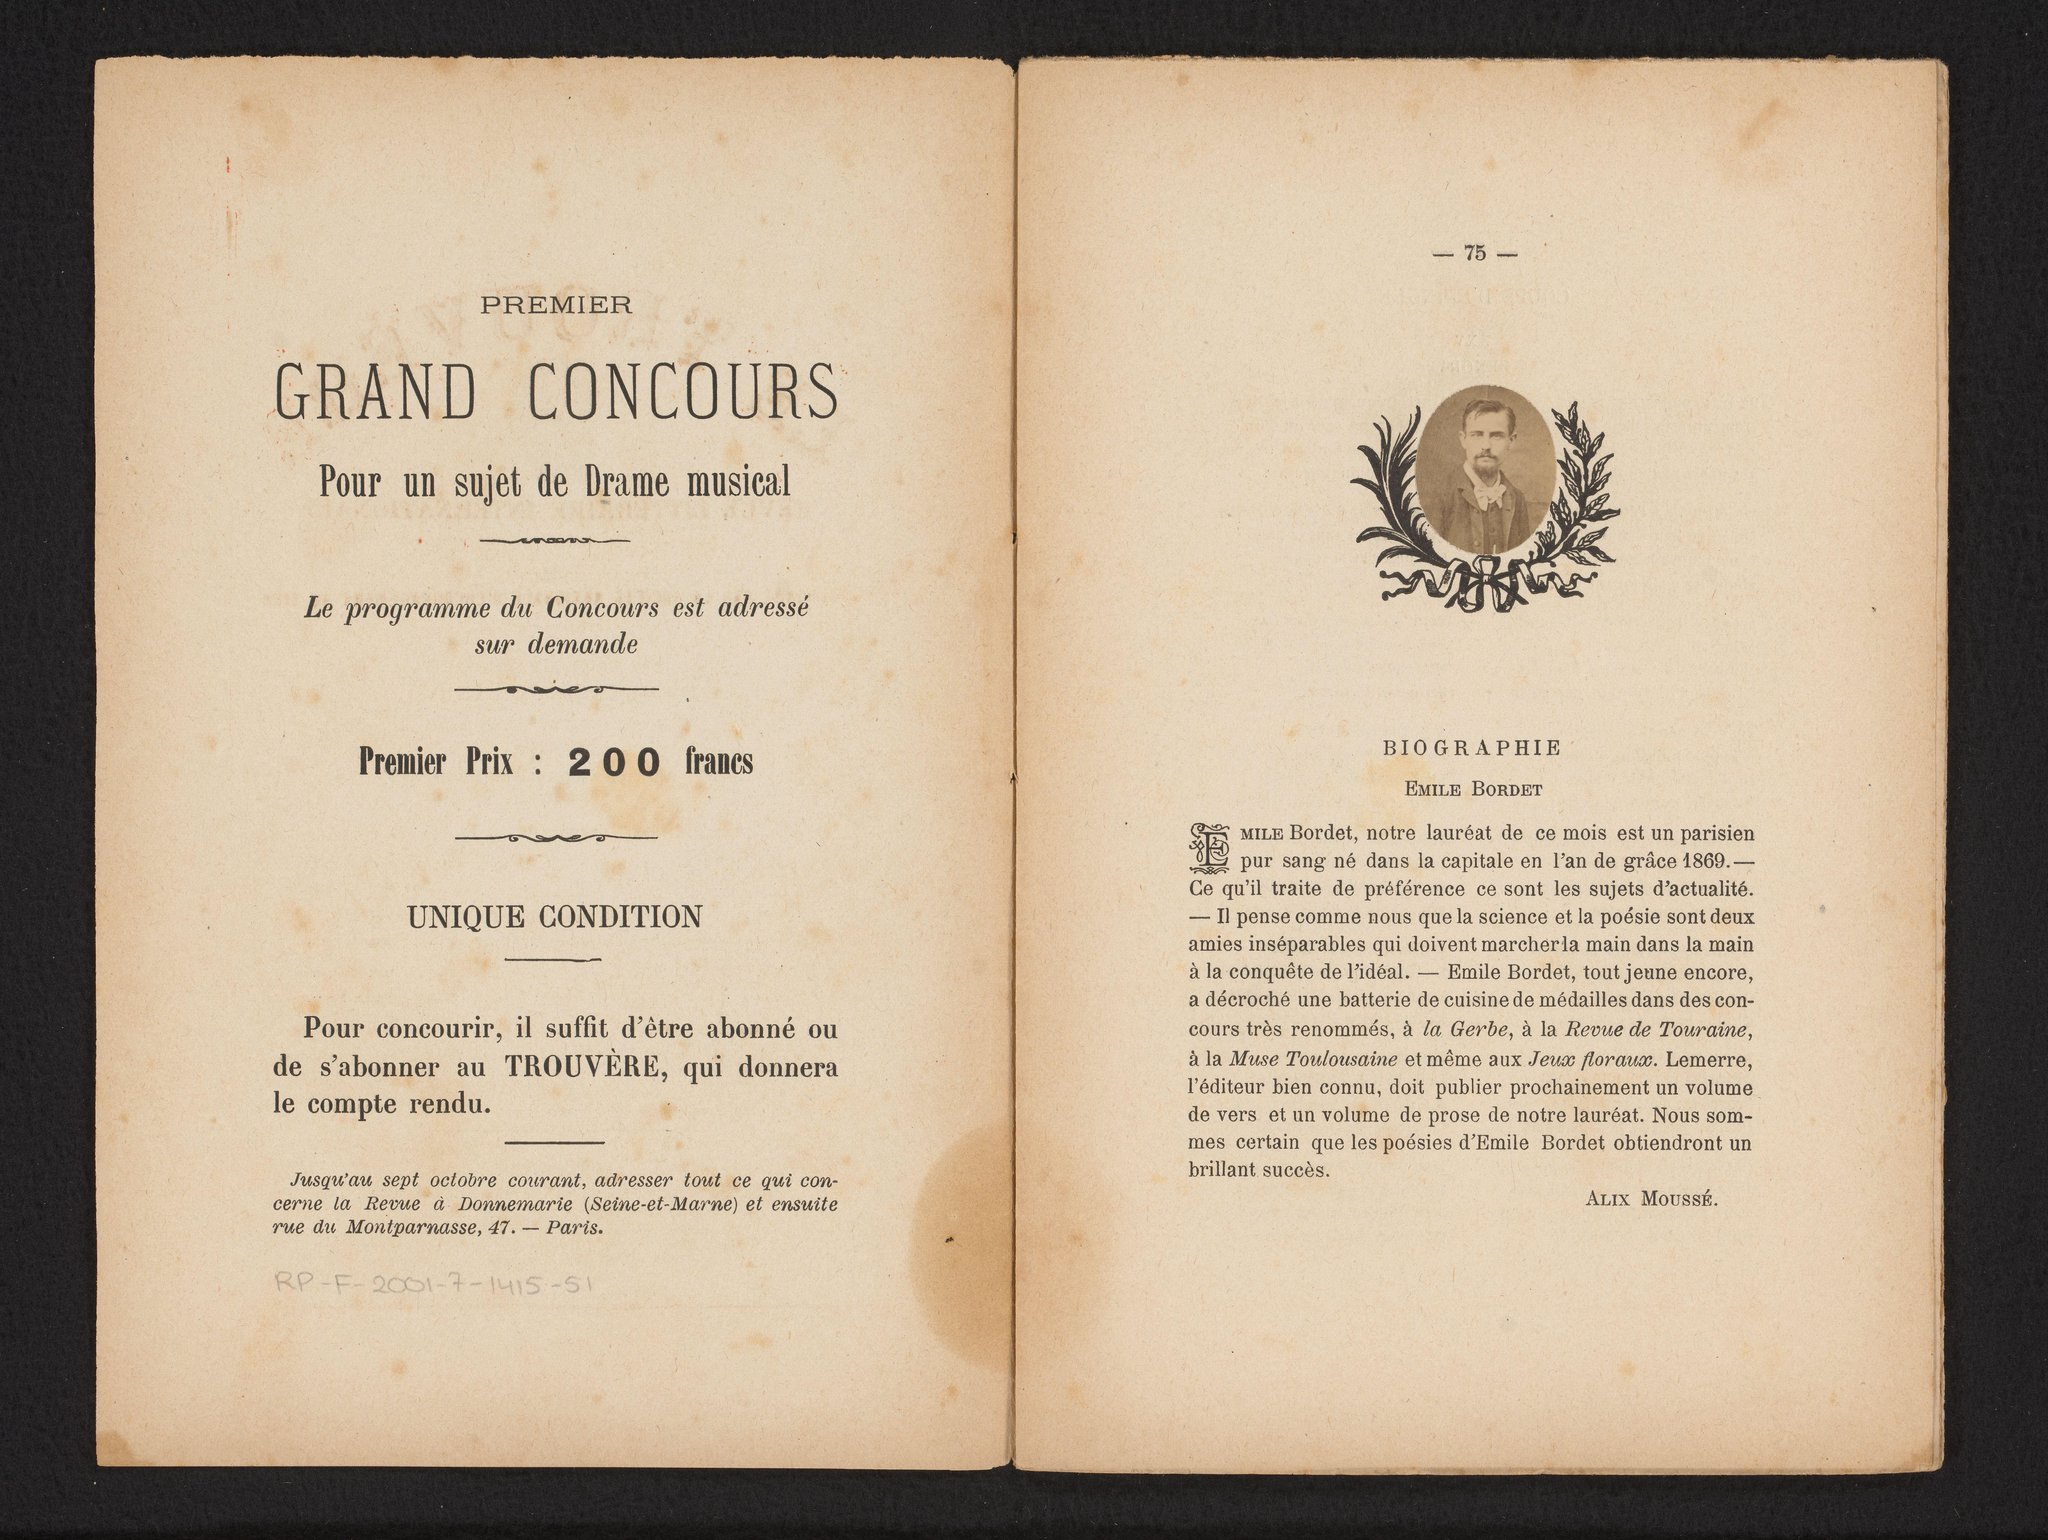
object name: photograph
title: Portret van Emile Bordet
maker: Anonymous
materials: photographic support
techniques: albumen print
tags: historical persons